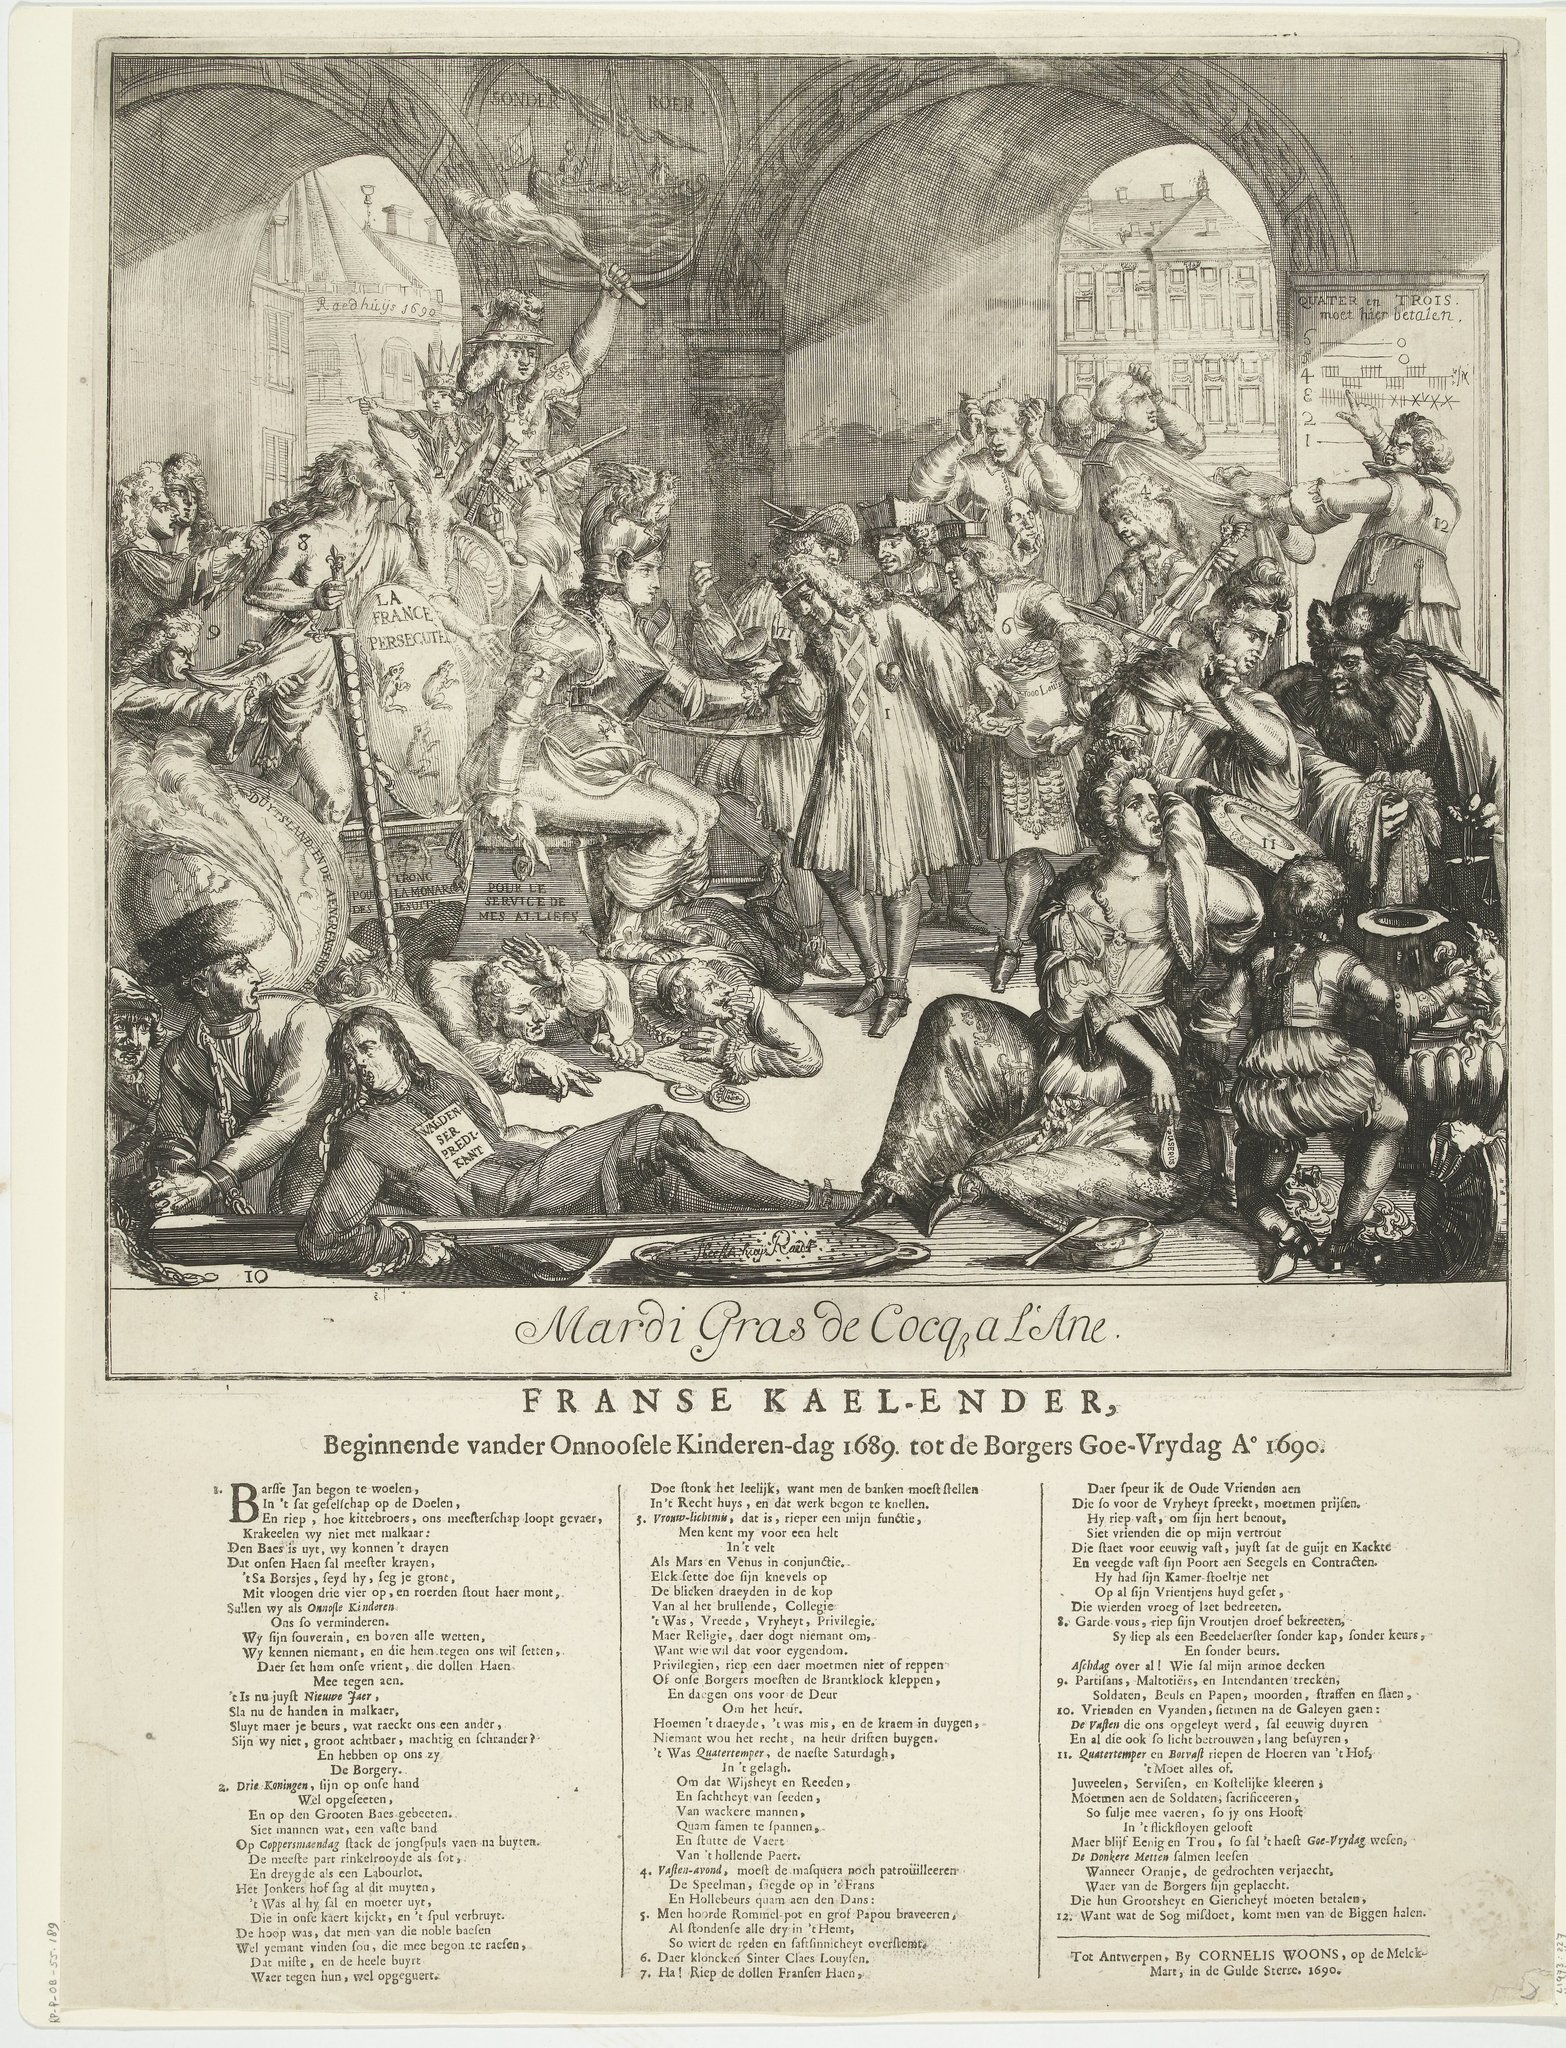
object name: print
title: Franse Kael-ender, Beginnende vander Onoosele Kinderen-dag 1689. tot de Borgers Goe-Vrydag Ao. 1690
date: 1690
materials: paper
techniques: etching, letterpress printing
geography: netherlands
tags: william iii (prince of orange and king of england, scotland, and ireland), lodewijk xiv (koning van frankrijk), dauphin van frankrijk lodewijk, rome, amsterdam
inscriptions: date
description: Spotprent op de onenigheden tussen Willem III en Amsterdam, 1690. De stad wordt beschuldigd van het heulen met Frankrijk. Een man met het wapen van Amsterdam op het hemd staande voor geharnaste Frankrijk die op een toilet zit en zijn achterste afveegt met de privileges. Hierachter de dauphin op een ezel en toorts in de hand. Voor hem zit het ondergeschoven kind of molenaarskind (met molentje): Jacobus Frans Eduard. Rechtsvoor worden kostbaarheden verkocht aan een joodse handelaar. Op de achtergrond het stadhuis en de toren Swygh Utrecht van de Doelen van Amsterdam. Verder vele andere figuren. Onder de voorstelling een vers waarin een toelichting op de cijfers 1-12 in het Nederlands.